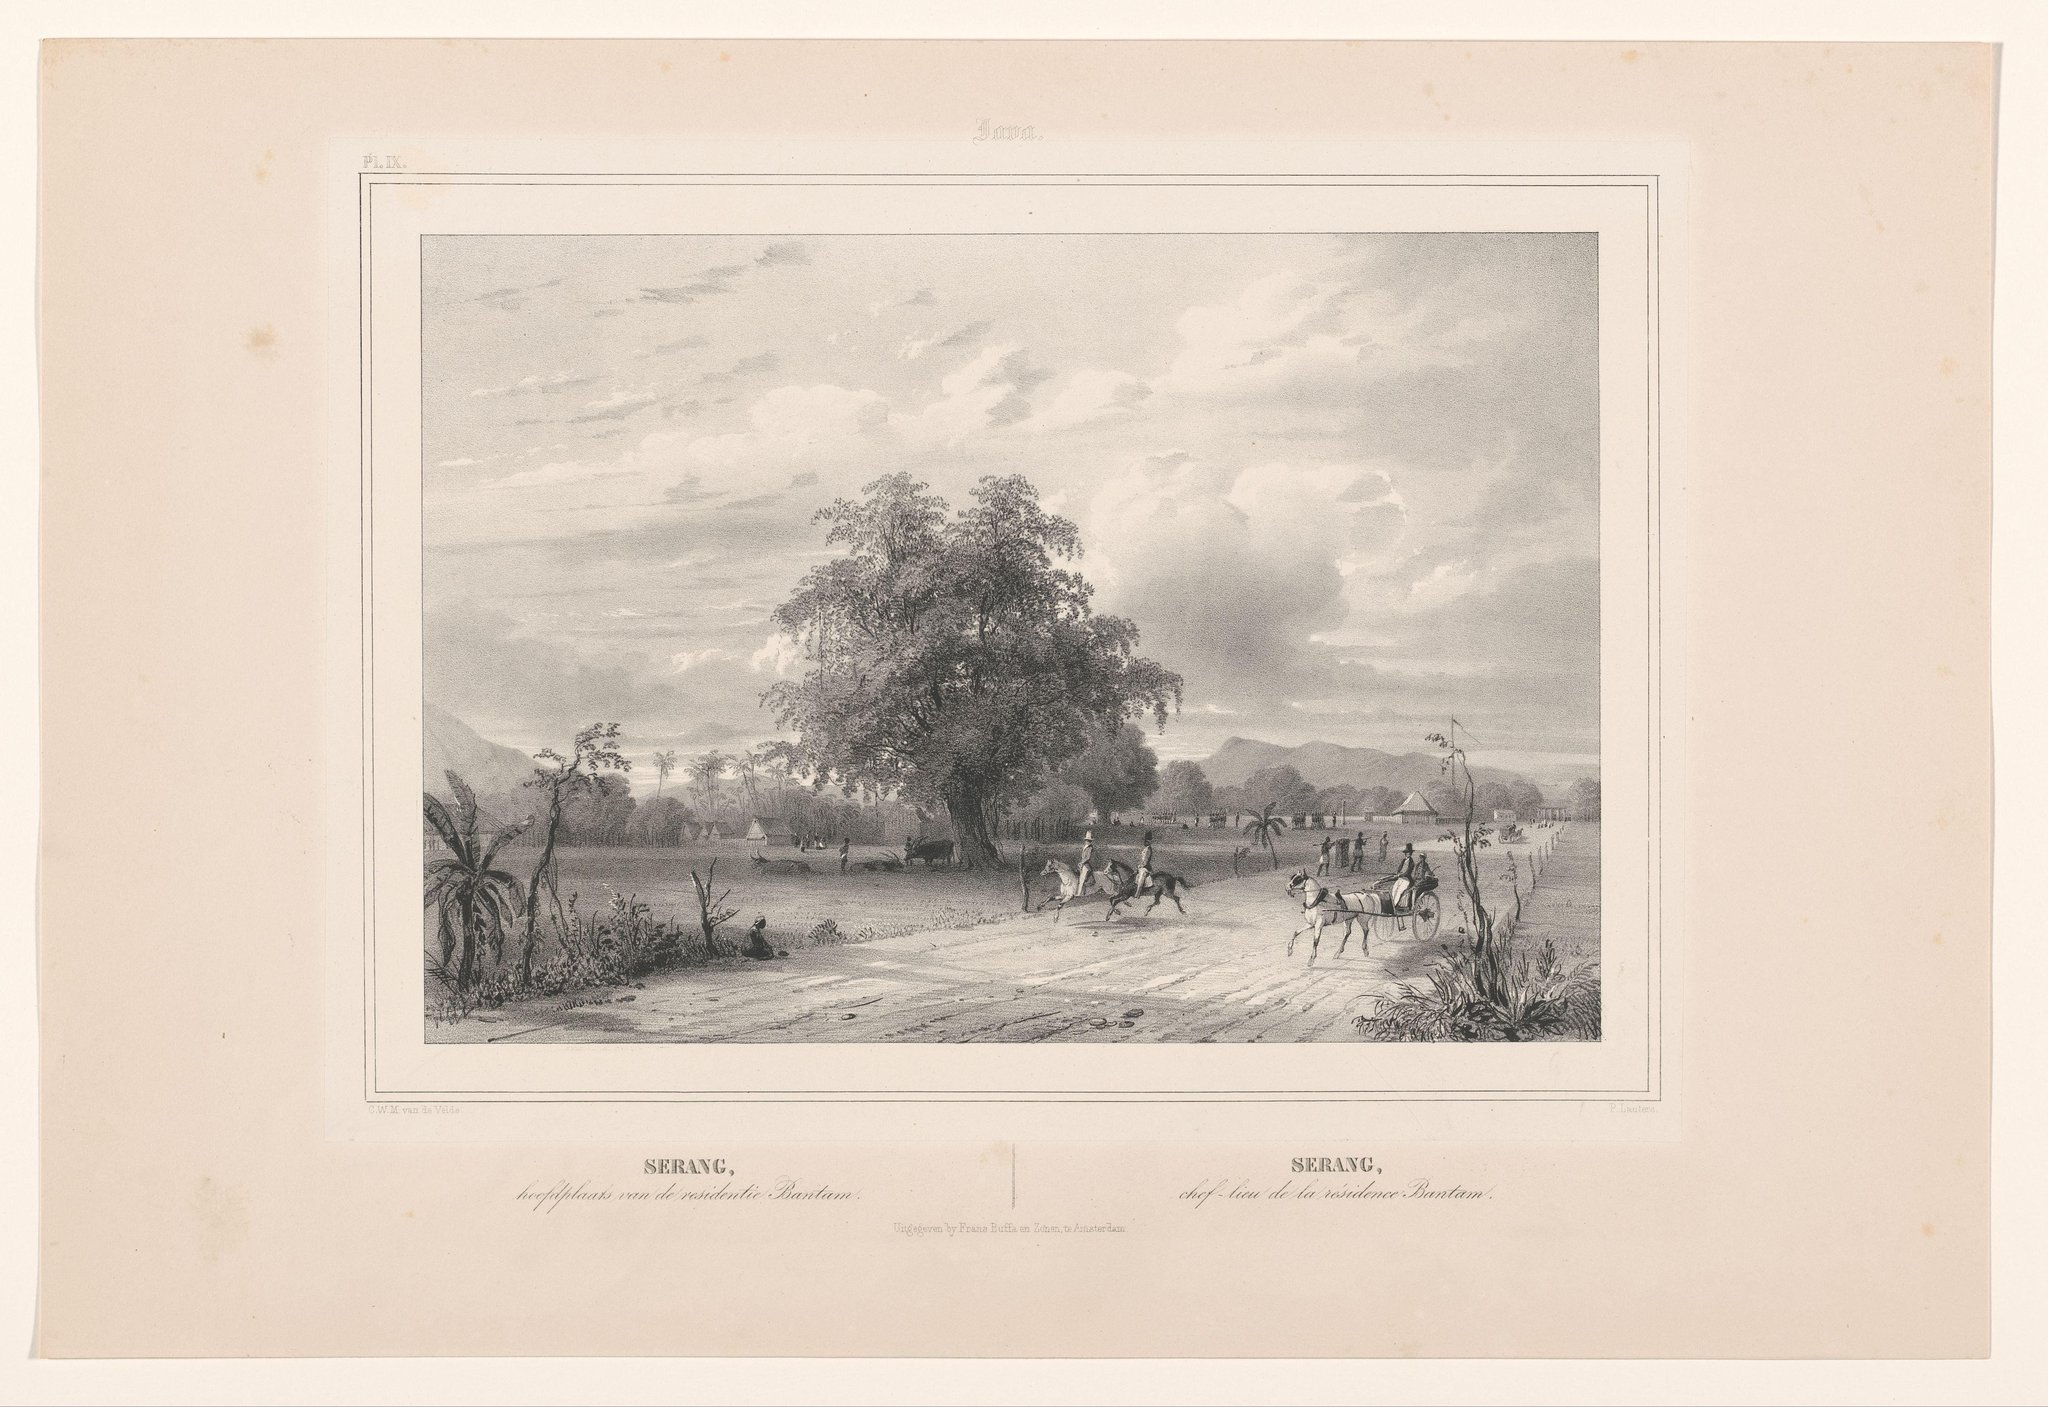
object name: print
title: Serang. Hoofdplaats van de residentie Bantam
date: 1843-1845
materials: paper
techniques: lithograph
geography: amsterdam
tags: street (+ city(-scape) with figures, staffage)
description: Genummerd linksboven: Pl. IX. De prent maakt deel uit van een omslag met zes bladen.